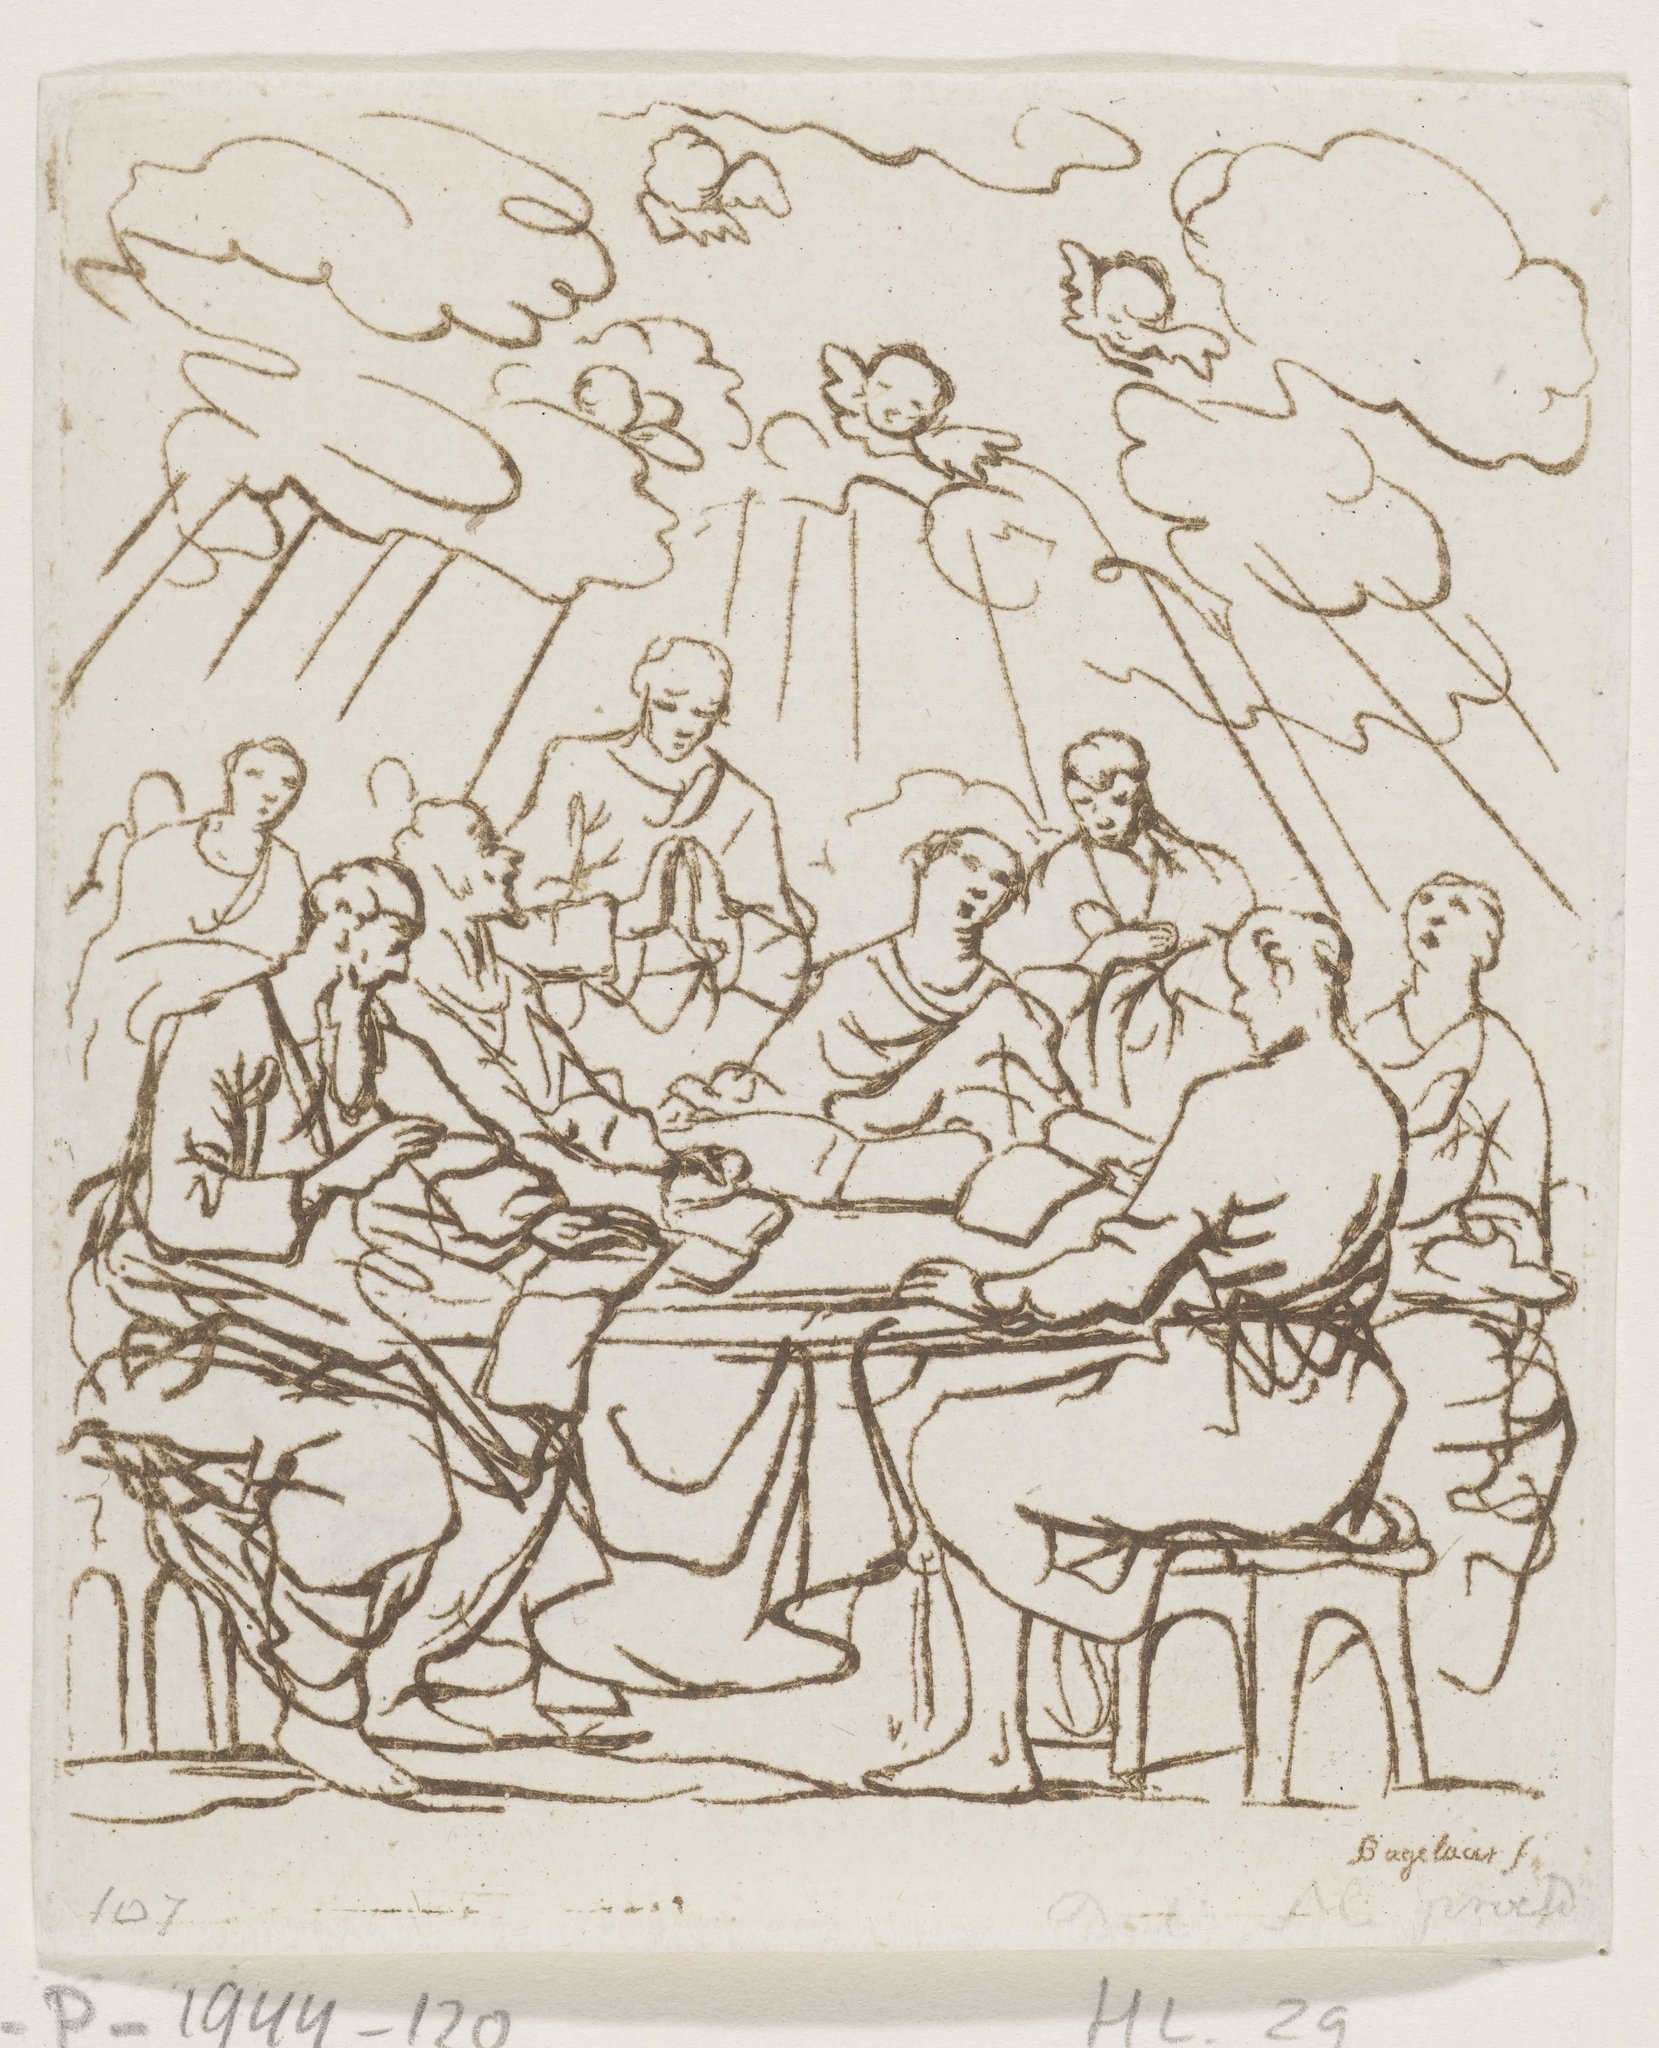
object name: print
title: Een gezelschap van acht lofzingende personen rondom een tafel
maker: ernst willem jan bagelaar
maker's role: draughtsman, print maker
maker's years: 1775-1837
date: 1798-1837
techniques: etching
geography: netherlands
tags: (public) prayer, last supper (in general) (matthew 26:21-35; mark 14:18-31; luke 22:3, 22:15-23; john 13:21-38)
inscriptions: collector's mark: Lugt 2228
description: naar een tekening in het Amsterdams Historisch Museum inv. no. TA13918